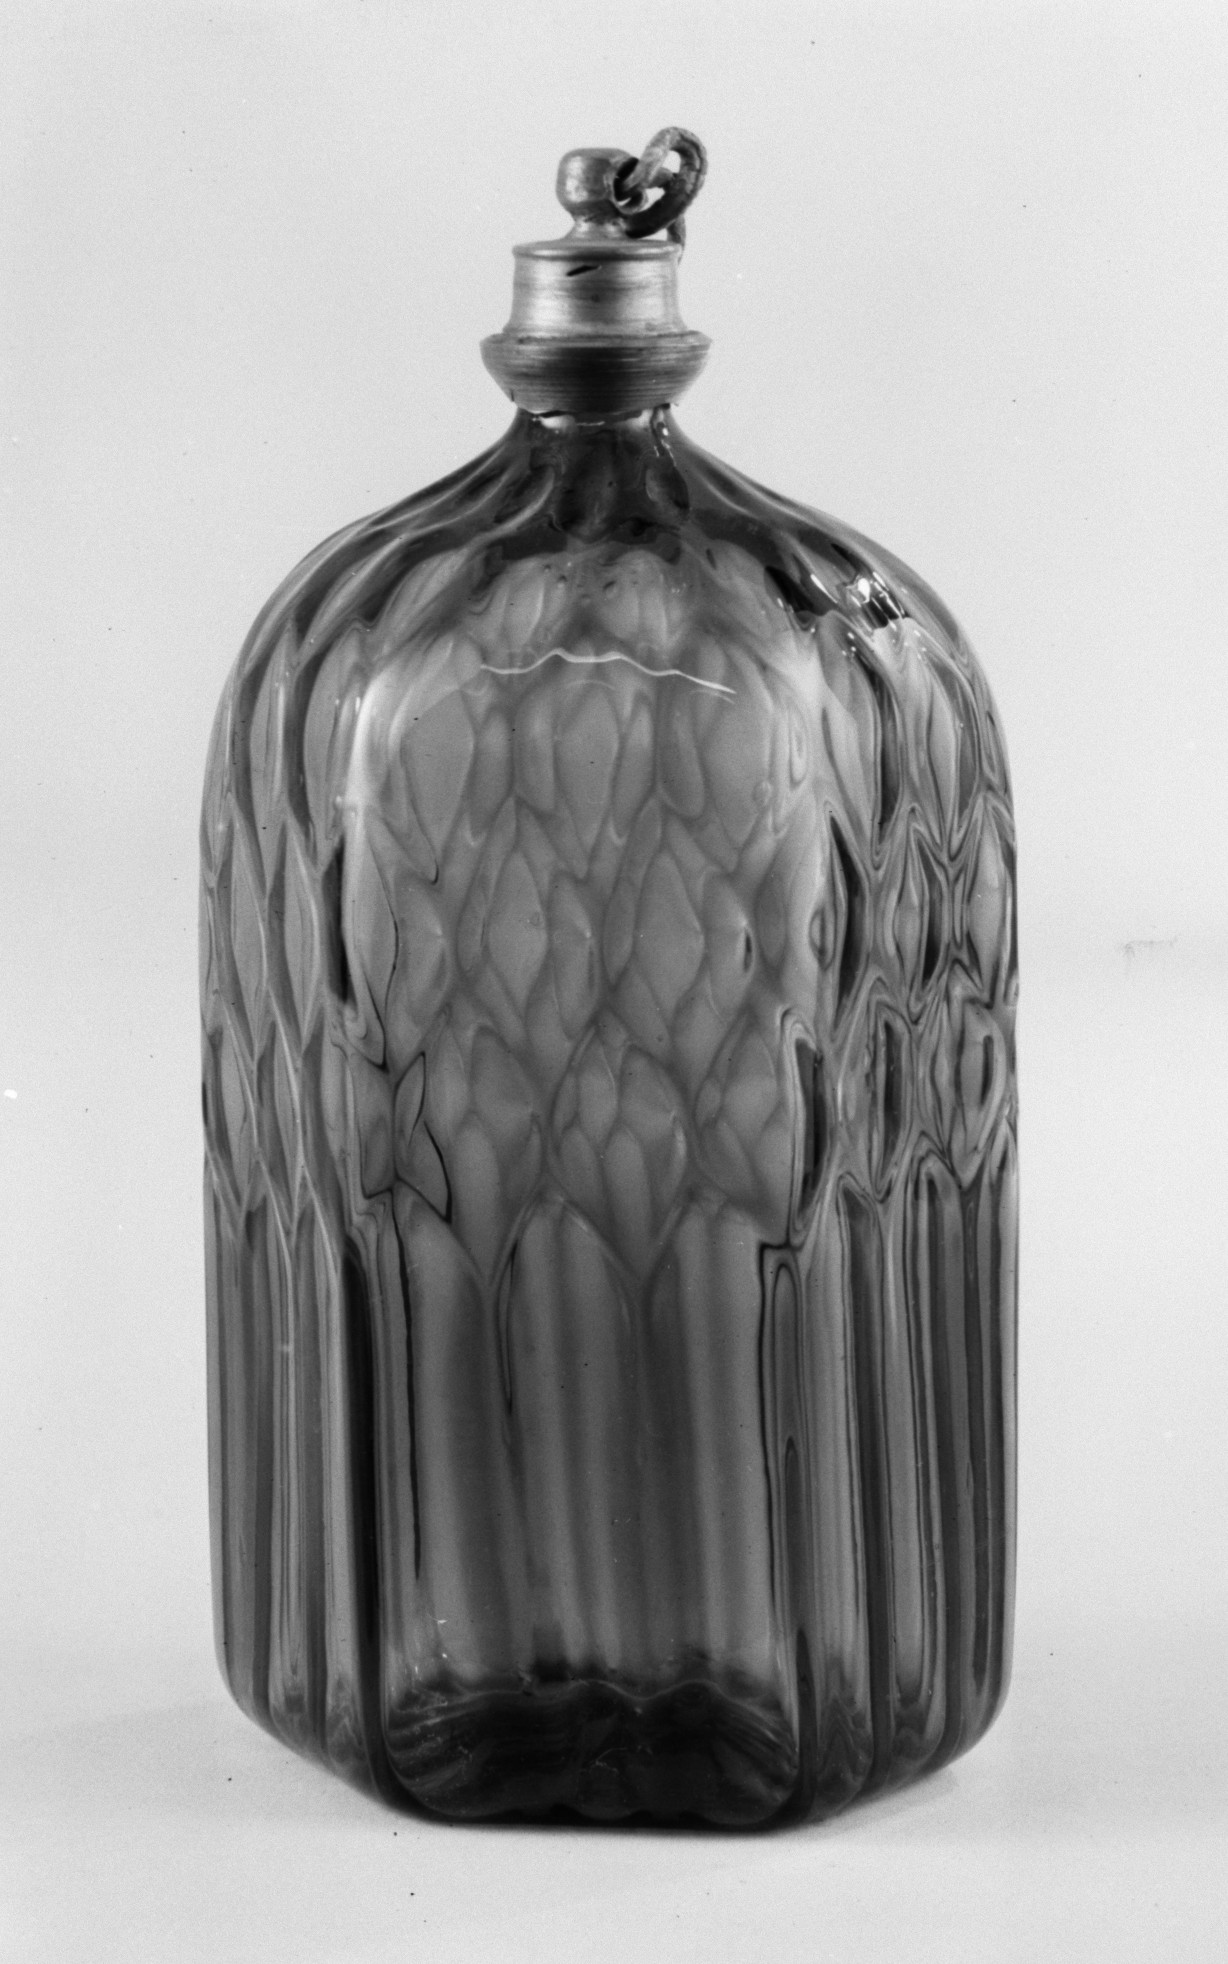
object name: bottle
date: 1701-1800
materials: glass, pewter